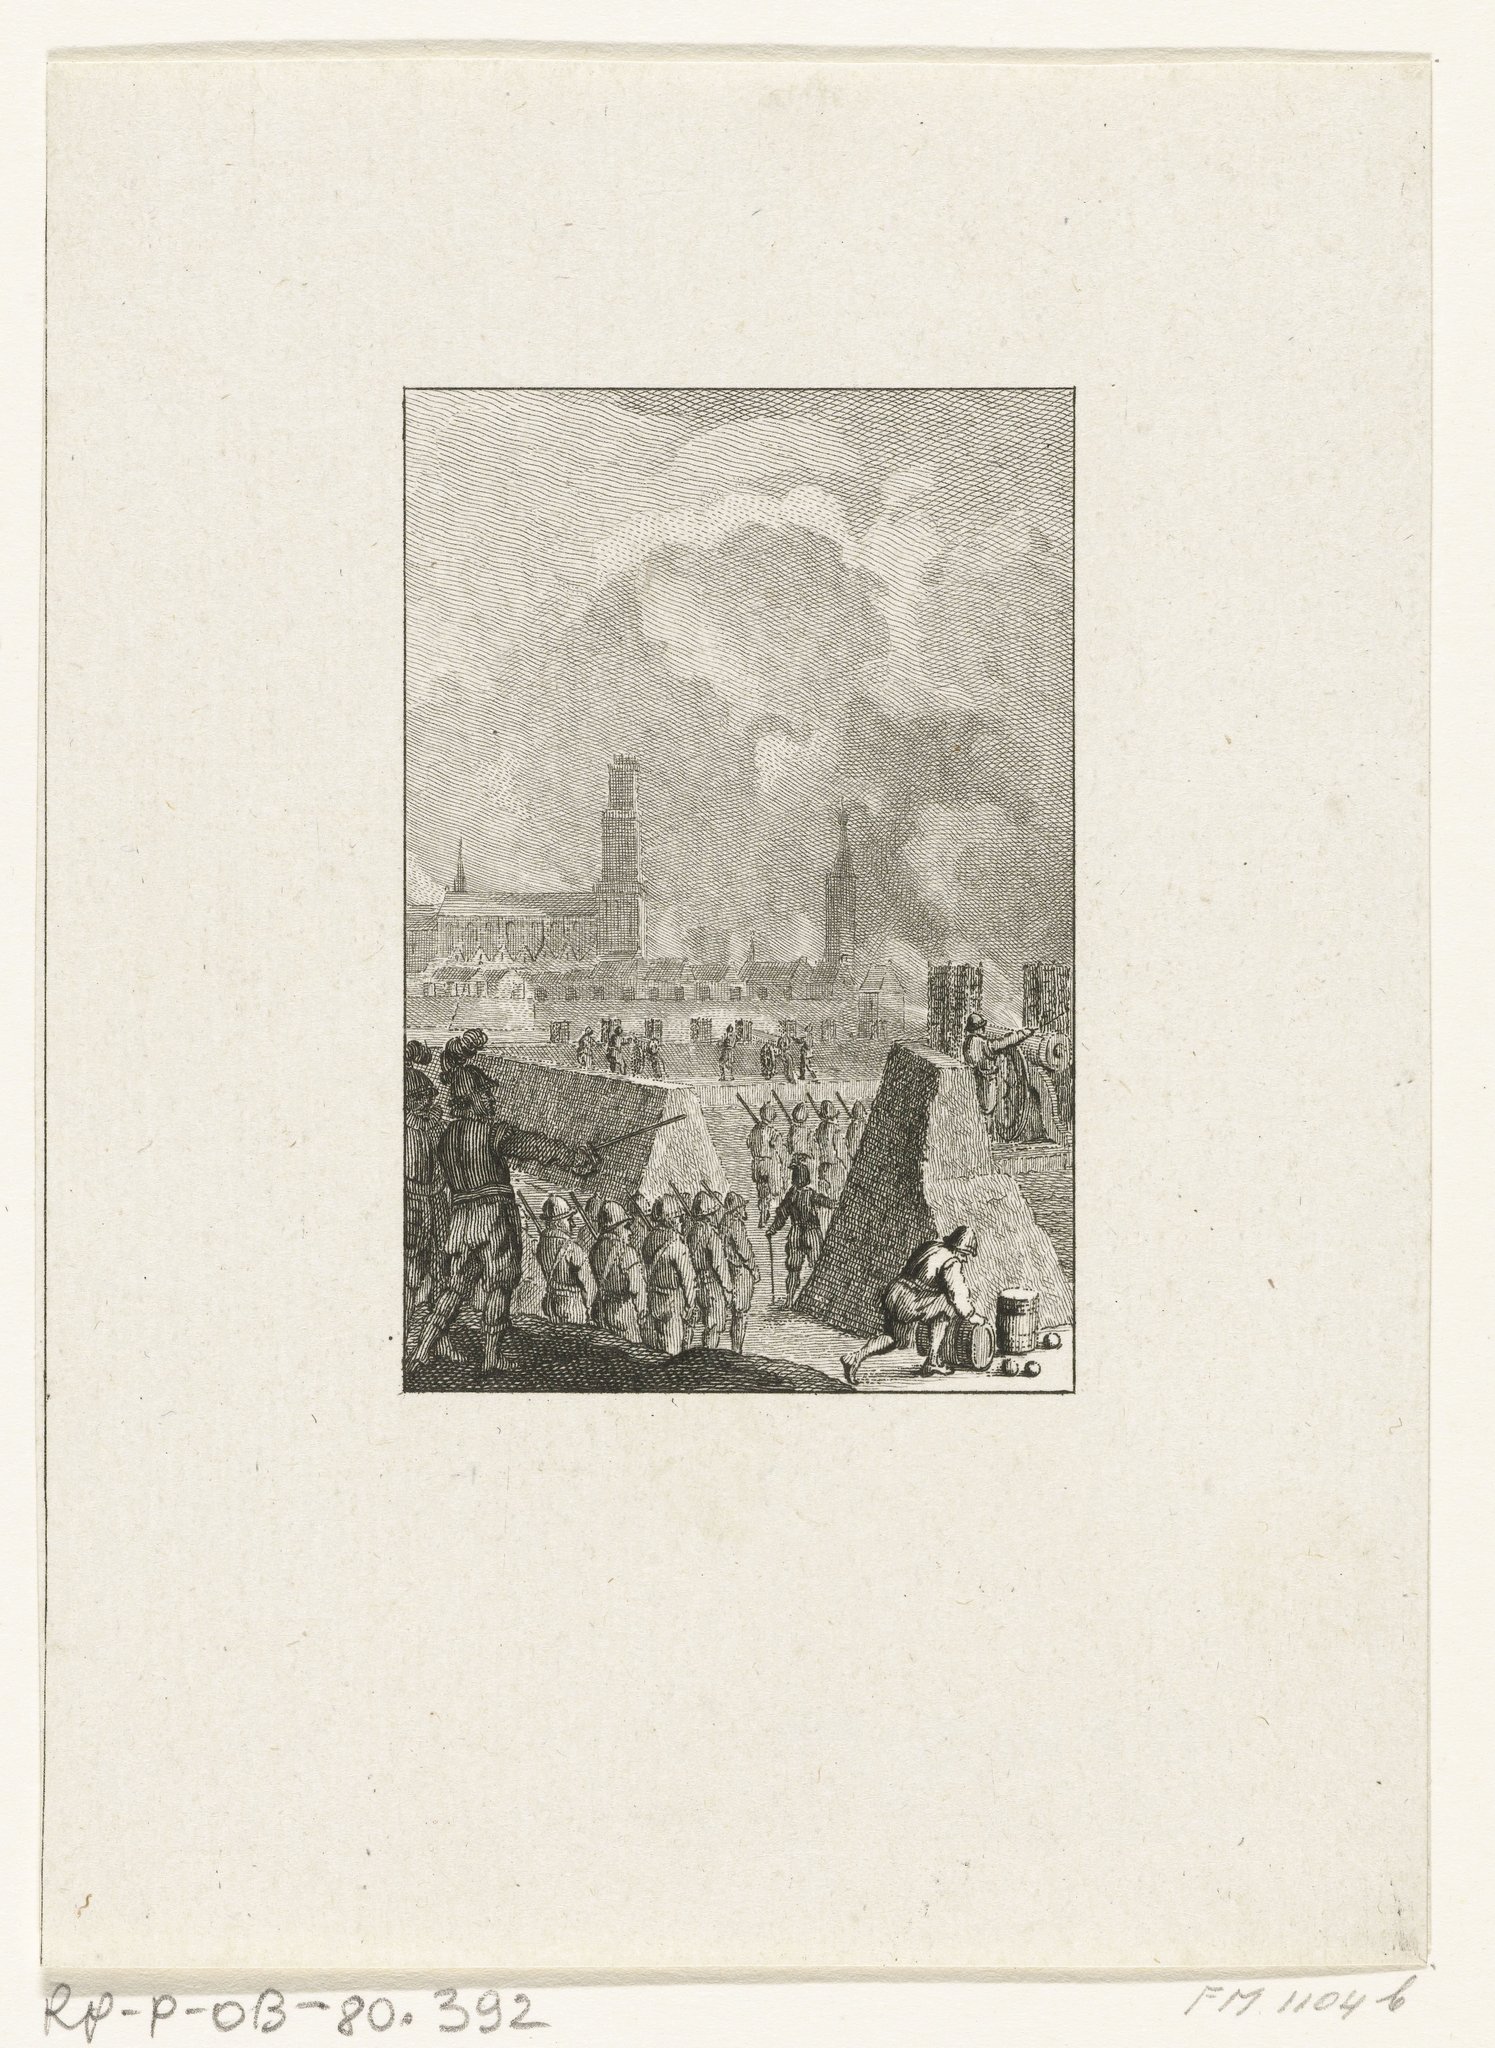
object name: history print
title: Beleg van Zaltbommel, 1599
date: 1780-1795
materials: paper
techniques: etching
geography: northern netherlands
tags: maurice (prince of orange), siege, position war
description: De belegering van de stad Zaltbommel door het Spaanse leger onder Mendoza en verdedigd door het Staatse leger onder Maurits, mei-juni 1599. Gezien vanuit de stellingen van de belegeraars.